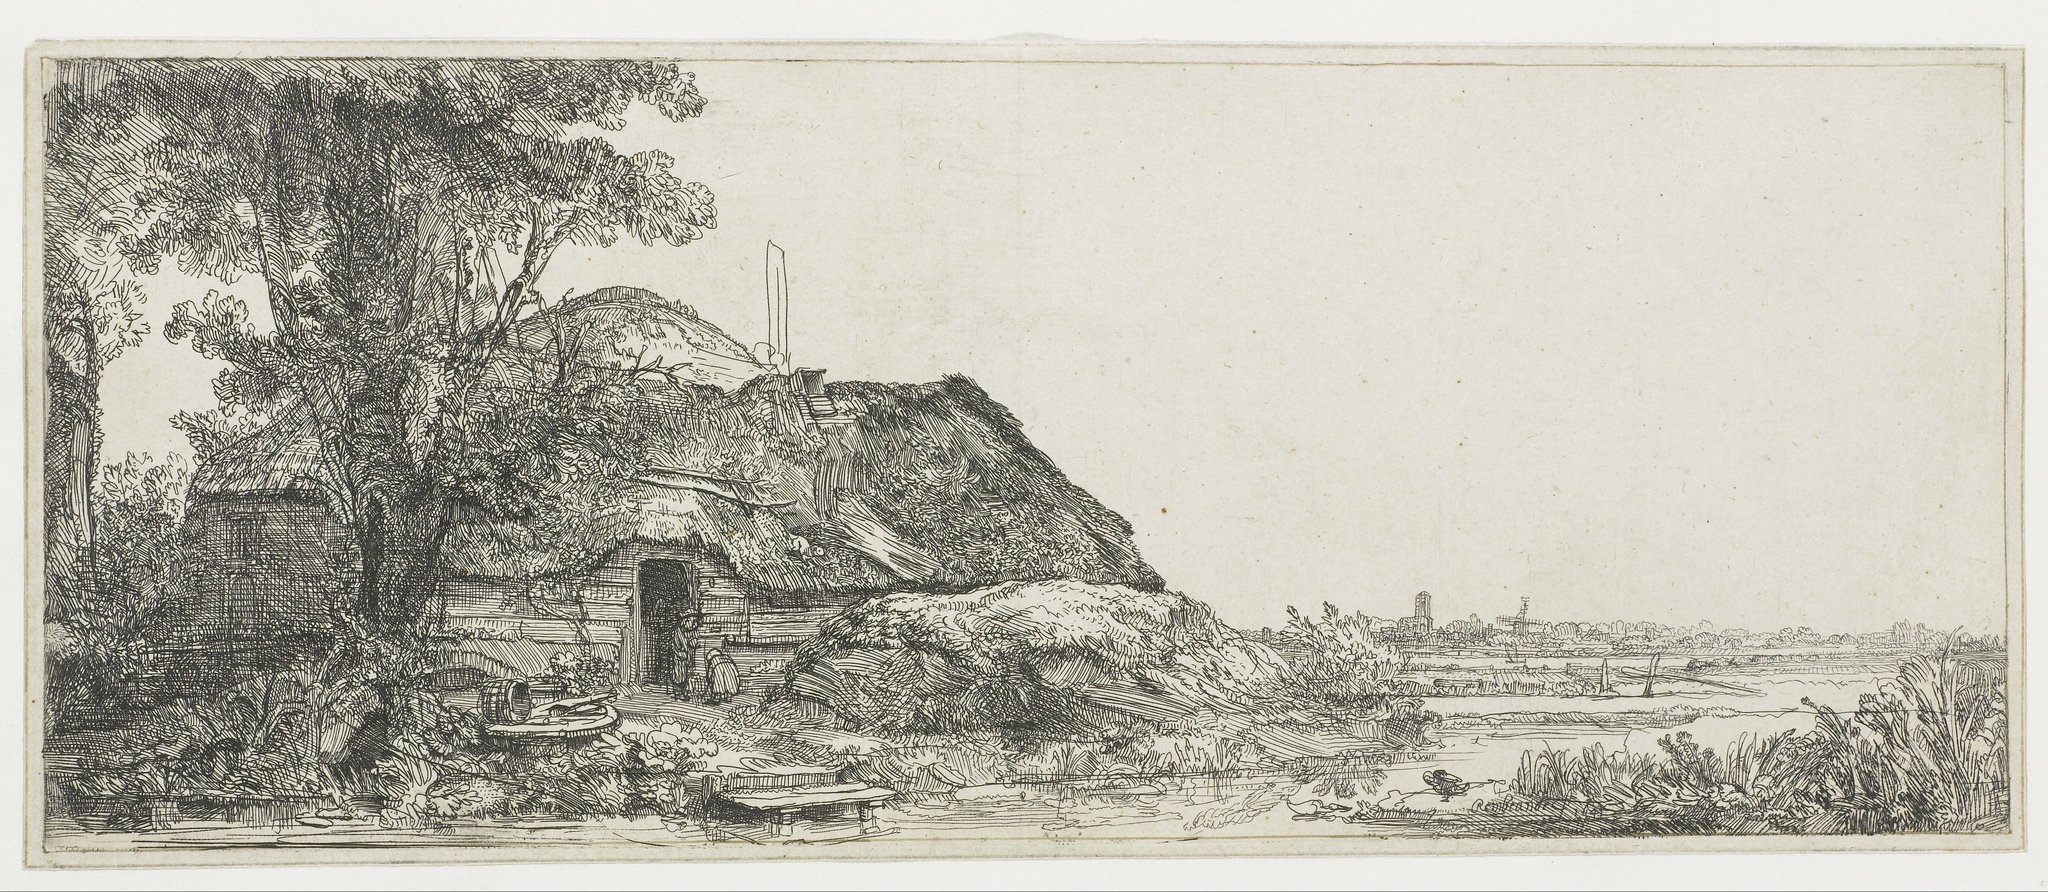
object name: print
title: Landscape with a cottage and a large tree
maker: rembrandt van rijn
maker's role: draughtsman, painter, print maker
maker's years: 1606-1669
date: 1641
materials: ink, paper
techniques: etching, pen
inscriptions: collector's mark: Lugt 240, signature and date: ‘Rembrandt f 1641’